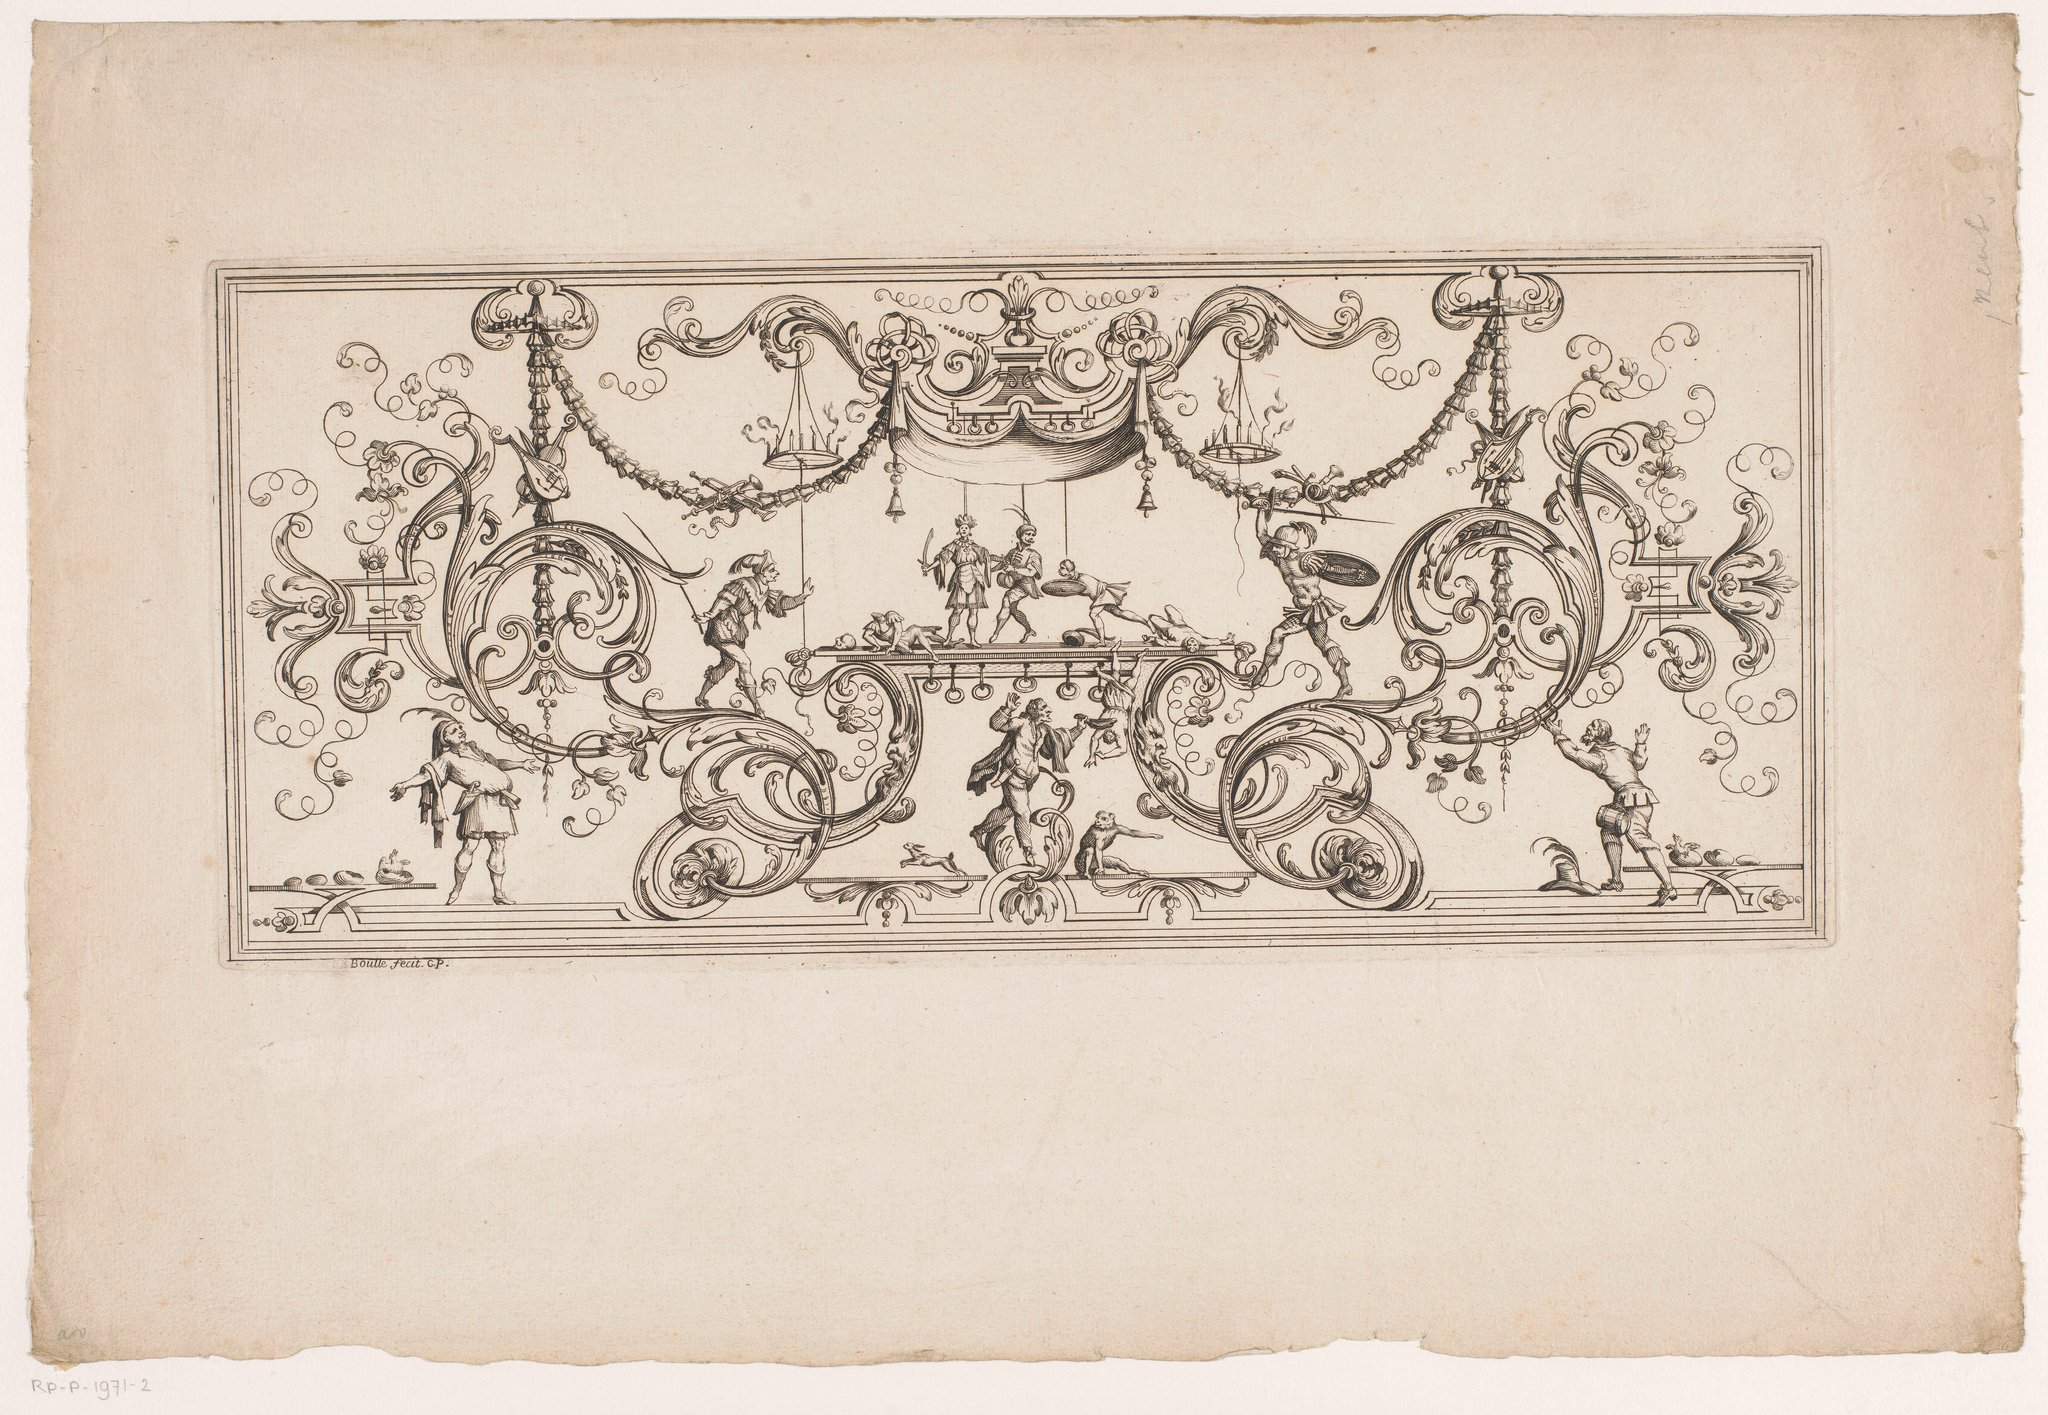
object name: ornament print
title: Groteske marqueterie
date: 1720-1739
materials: paper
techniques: etching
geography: paris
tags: ornament ~ grotesque, making marquetry ~ applied arts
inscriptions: collector's mark: Lugt 4172, collector's mark: Lugt 2760, collector's mark: Lugt 151, collector's mark: Lugt 2228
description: Ontwerp voor marqueterie met grotesken, ranken en menselijke figuren. In het midden onder een baldakijn staat een figuur met aan zwaard op een podium. Links van hem ligt een onthoofd lichaam. Rechts komen twee figuren met hoofddeksel aanlopen. Links van het podium staat een man met hoed en stok of zweep, rechts staat een man in harnas met zwaard en schild. Boven het podium hangen kroonluchters en guirlandes met muziekinstrumenten. Onder het podium, tussen de ranken staan drie mannen met dieren.